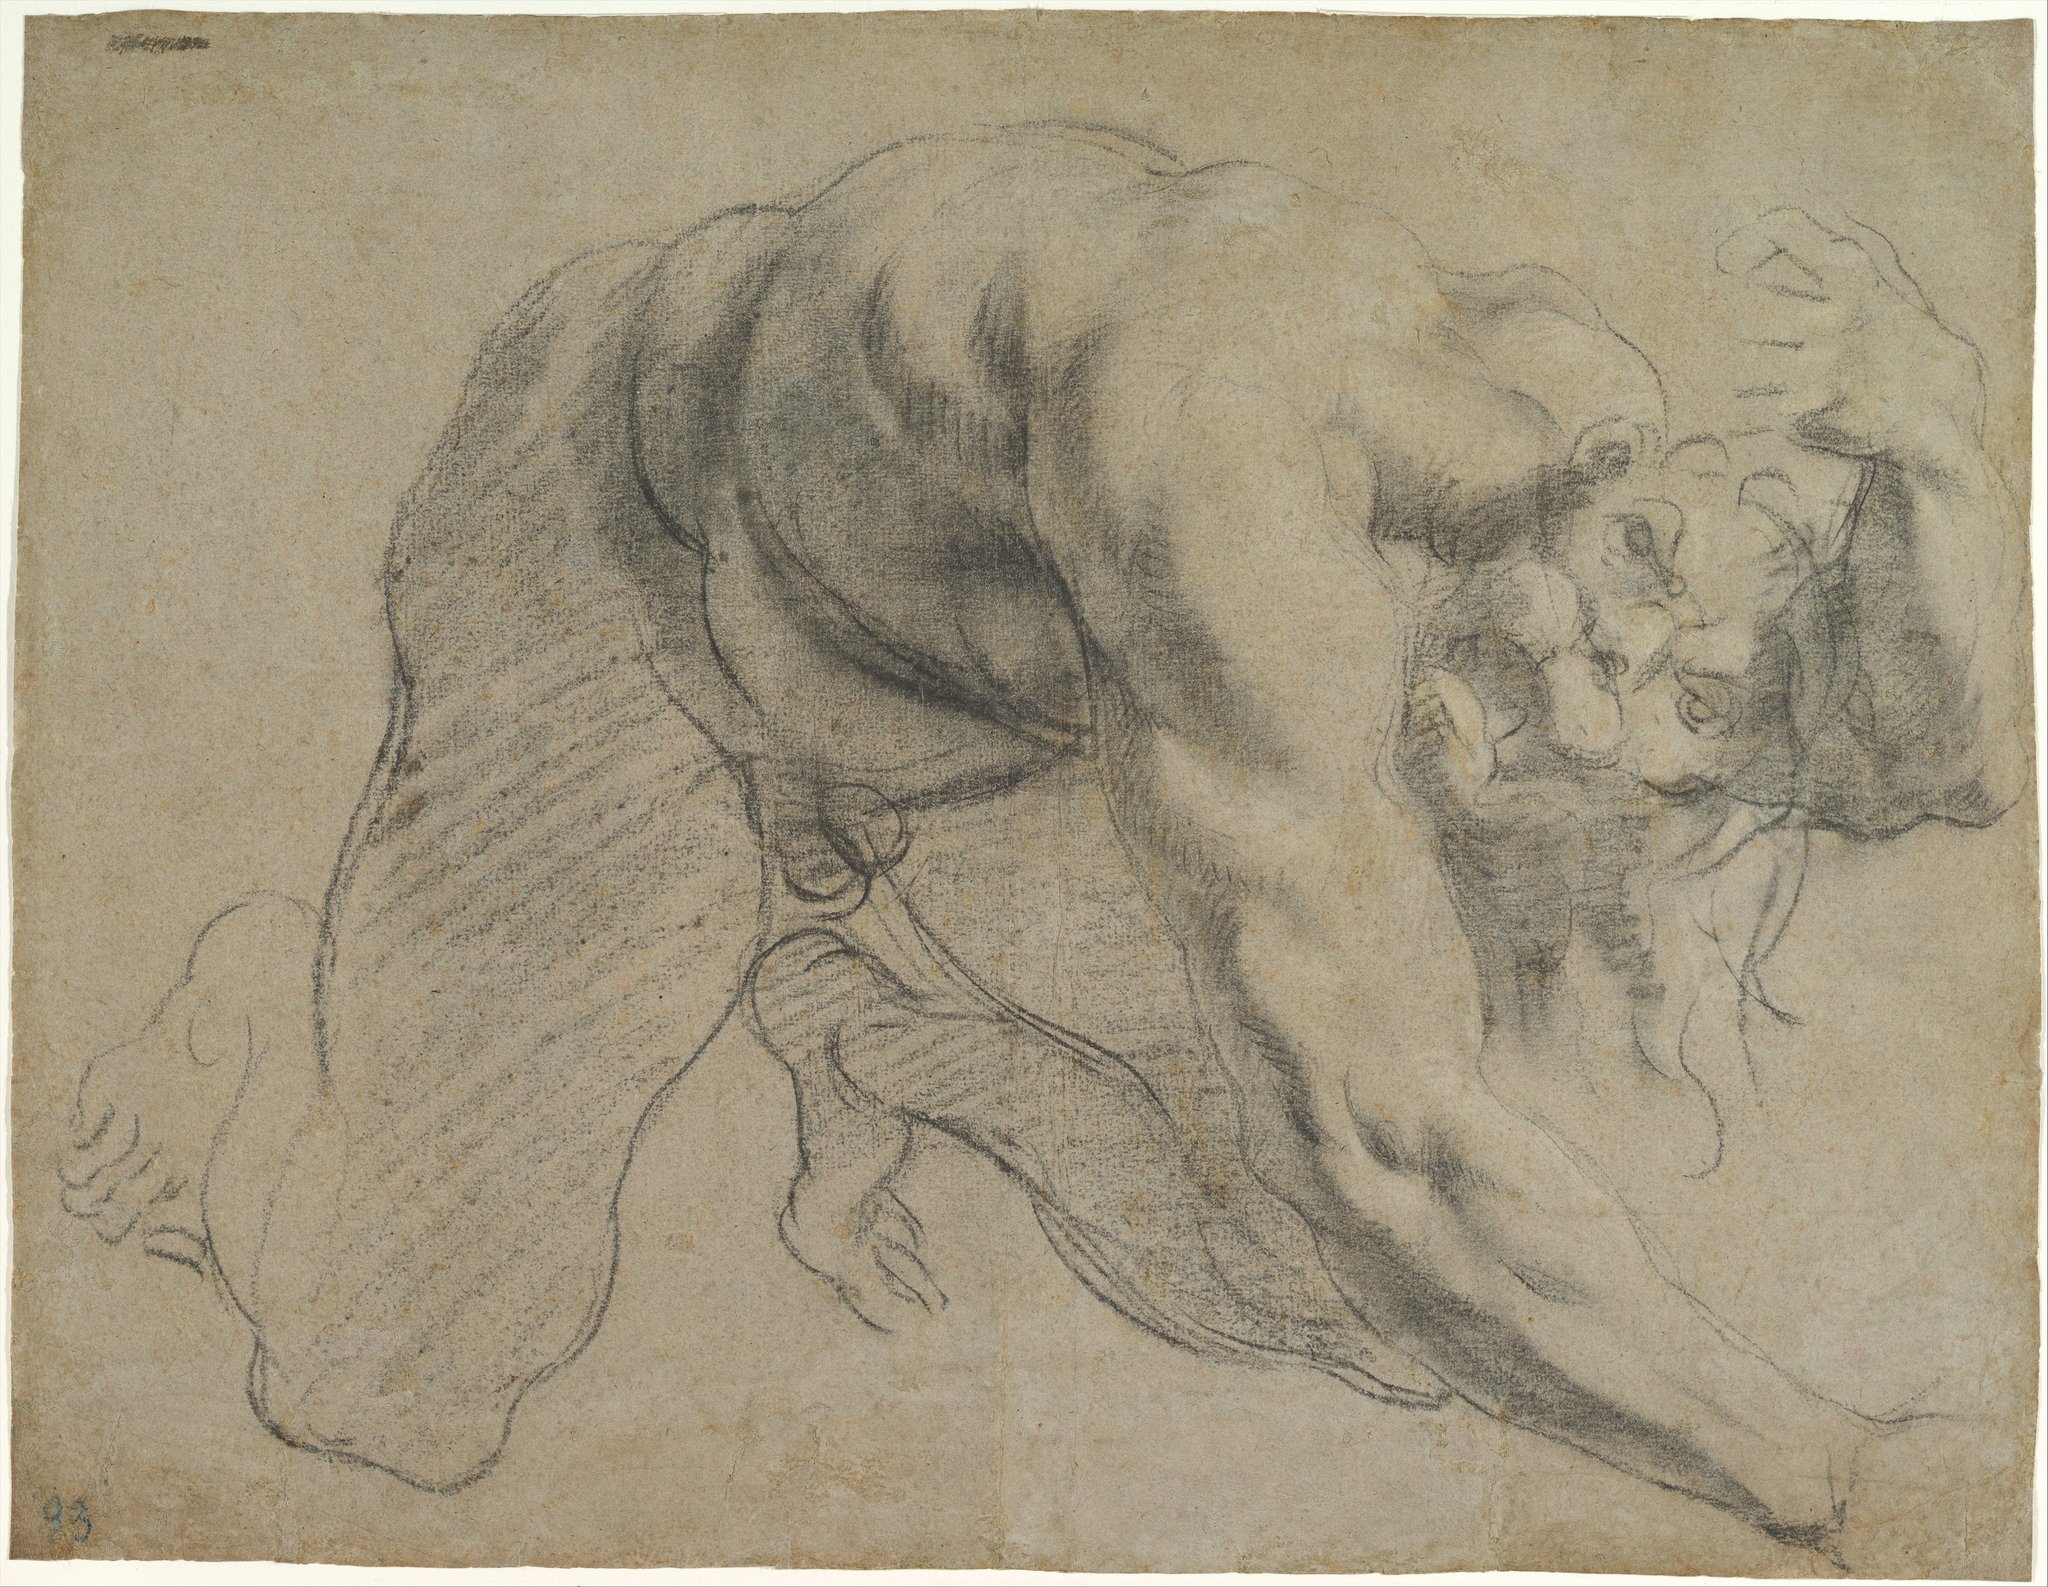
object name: drawing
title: Crawling Male Figure (Study for Cacus)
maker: annibale carracci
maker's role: artist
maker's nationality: italian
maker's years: 1560-1609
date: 1593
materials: chalk, charcoal, paper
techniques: highlighting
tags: men